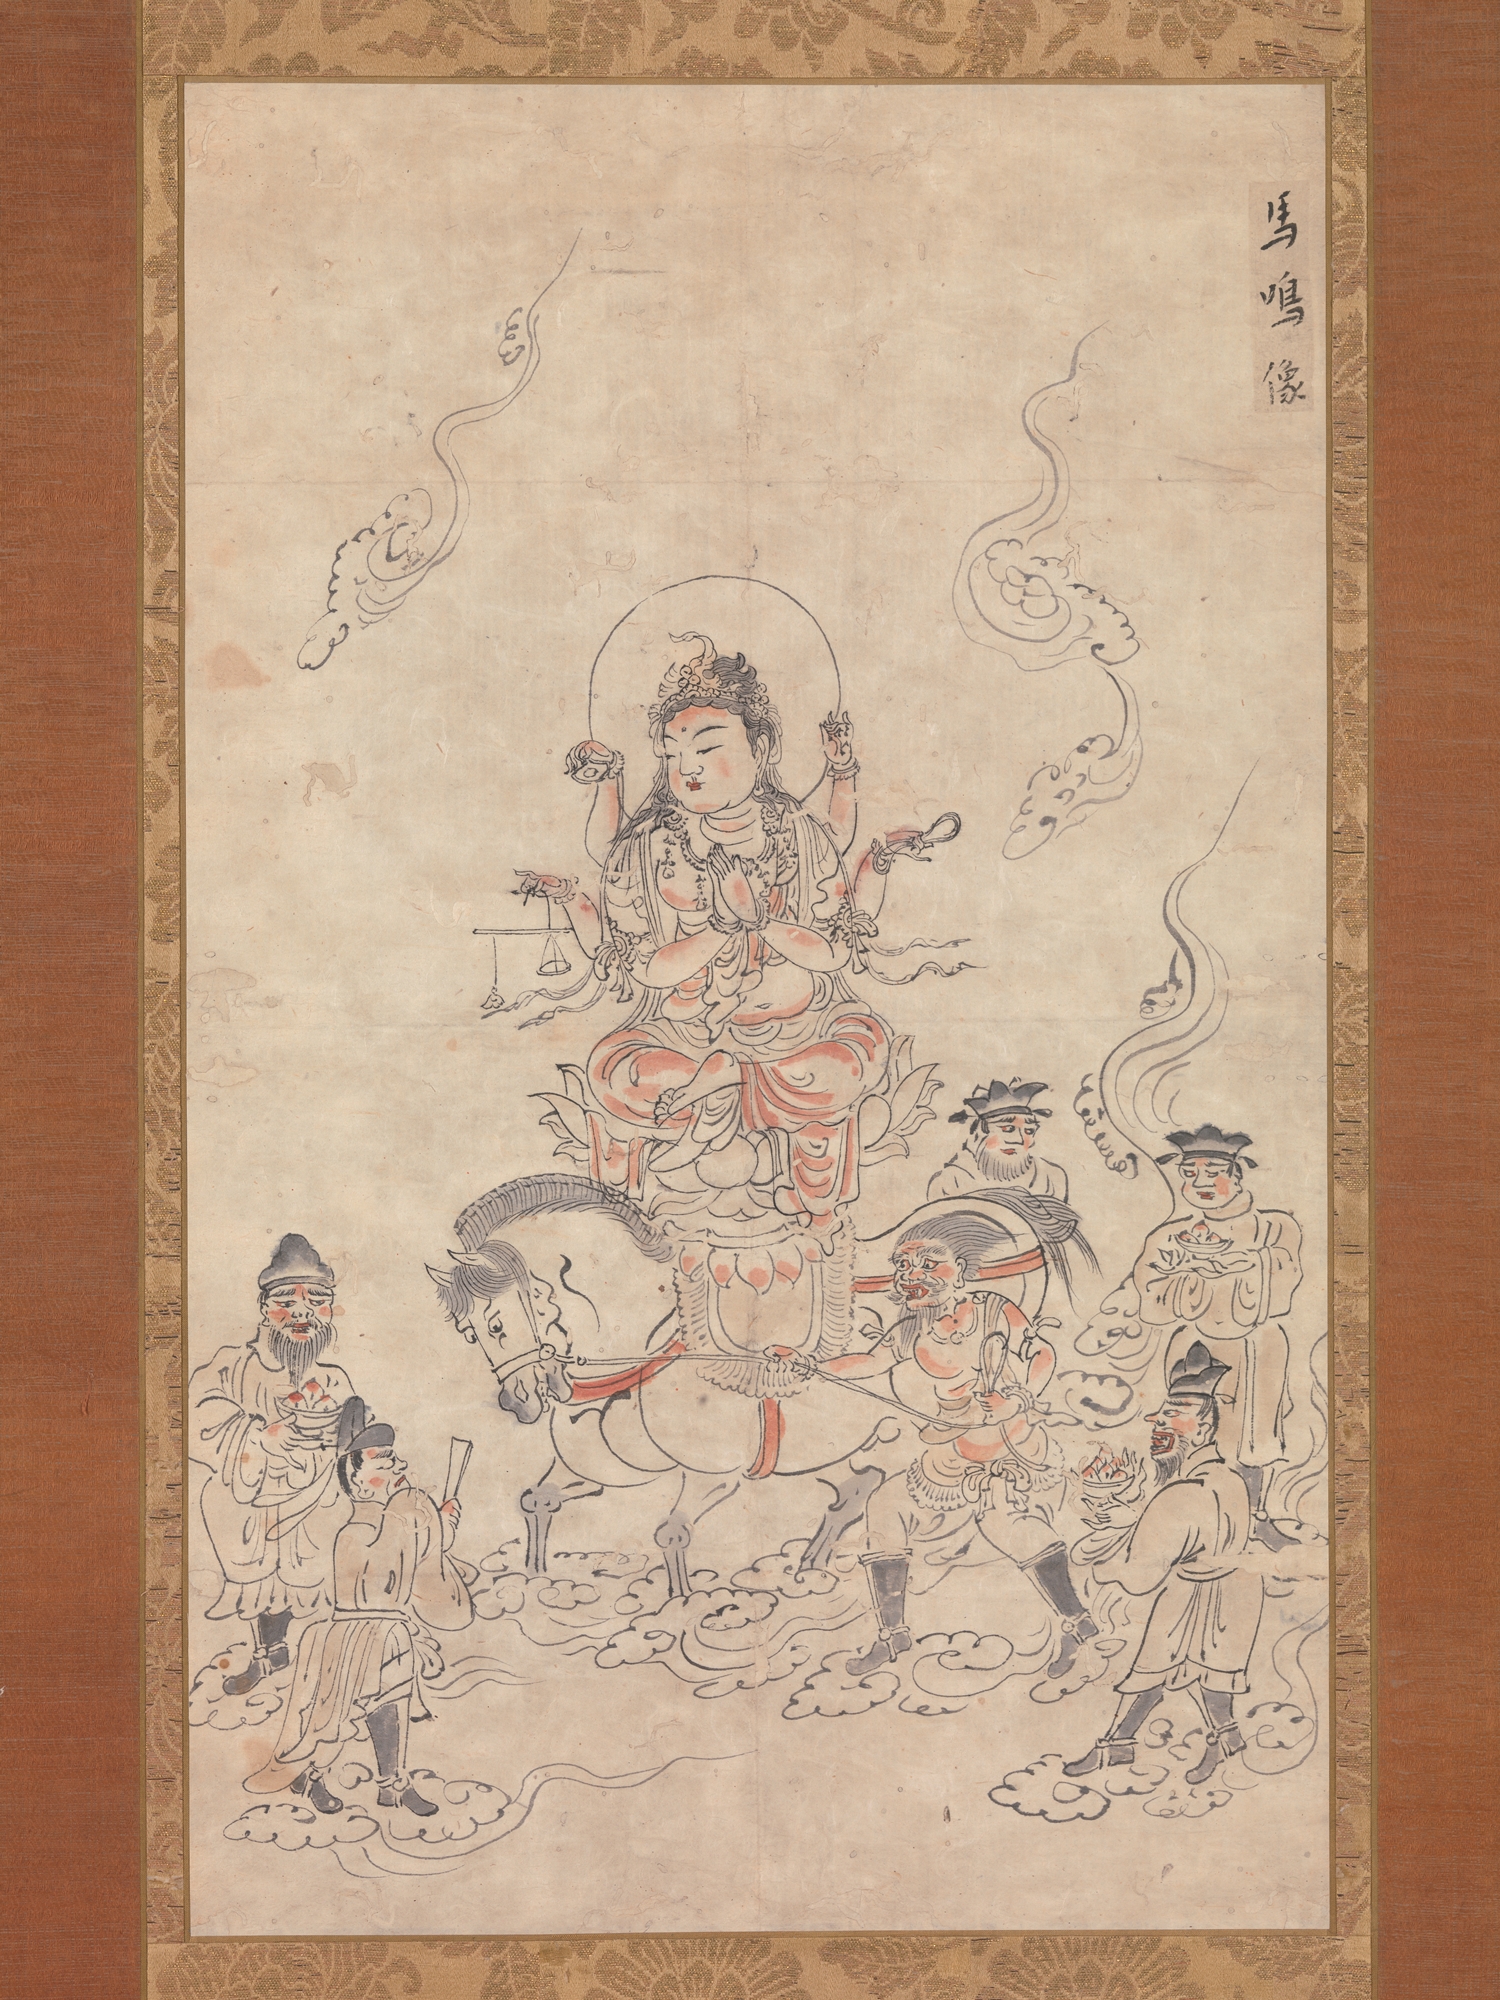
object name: hanging scroll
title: Iconographic Drawing of the Bodhisattva Memyō (Ashvaghosha)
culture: japanese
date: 1101-1200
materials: ink, paper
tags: men,horses,bodhisattvas